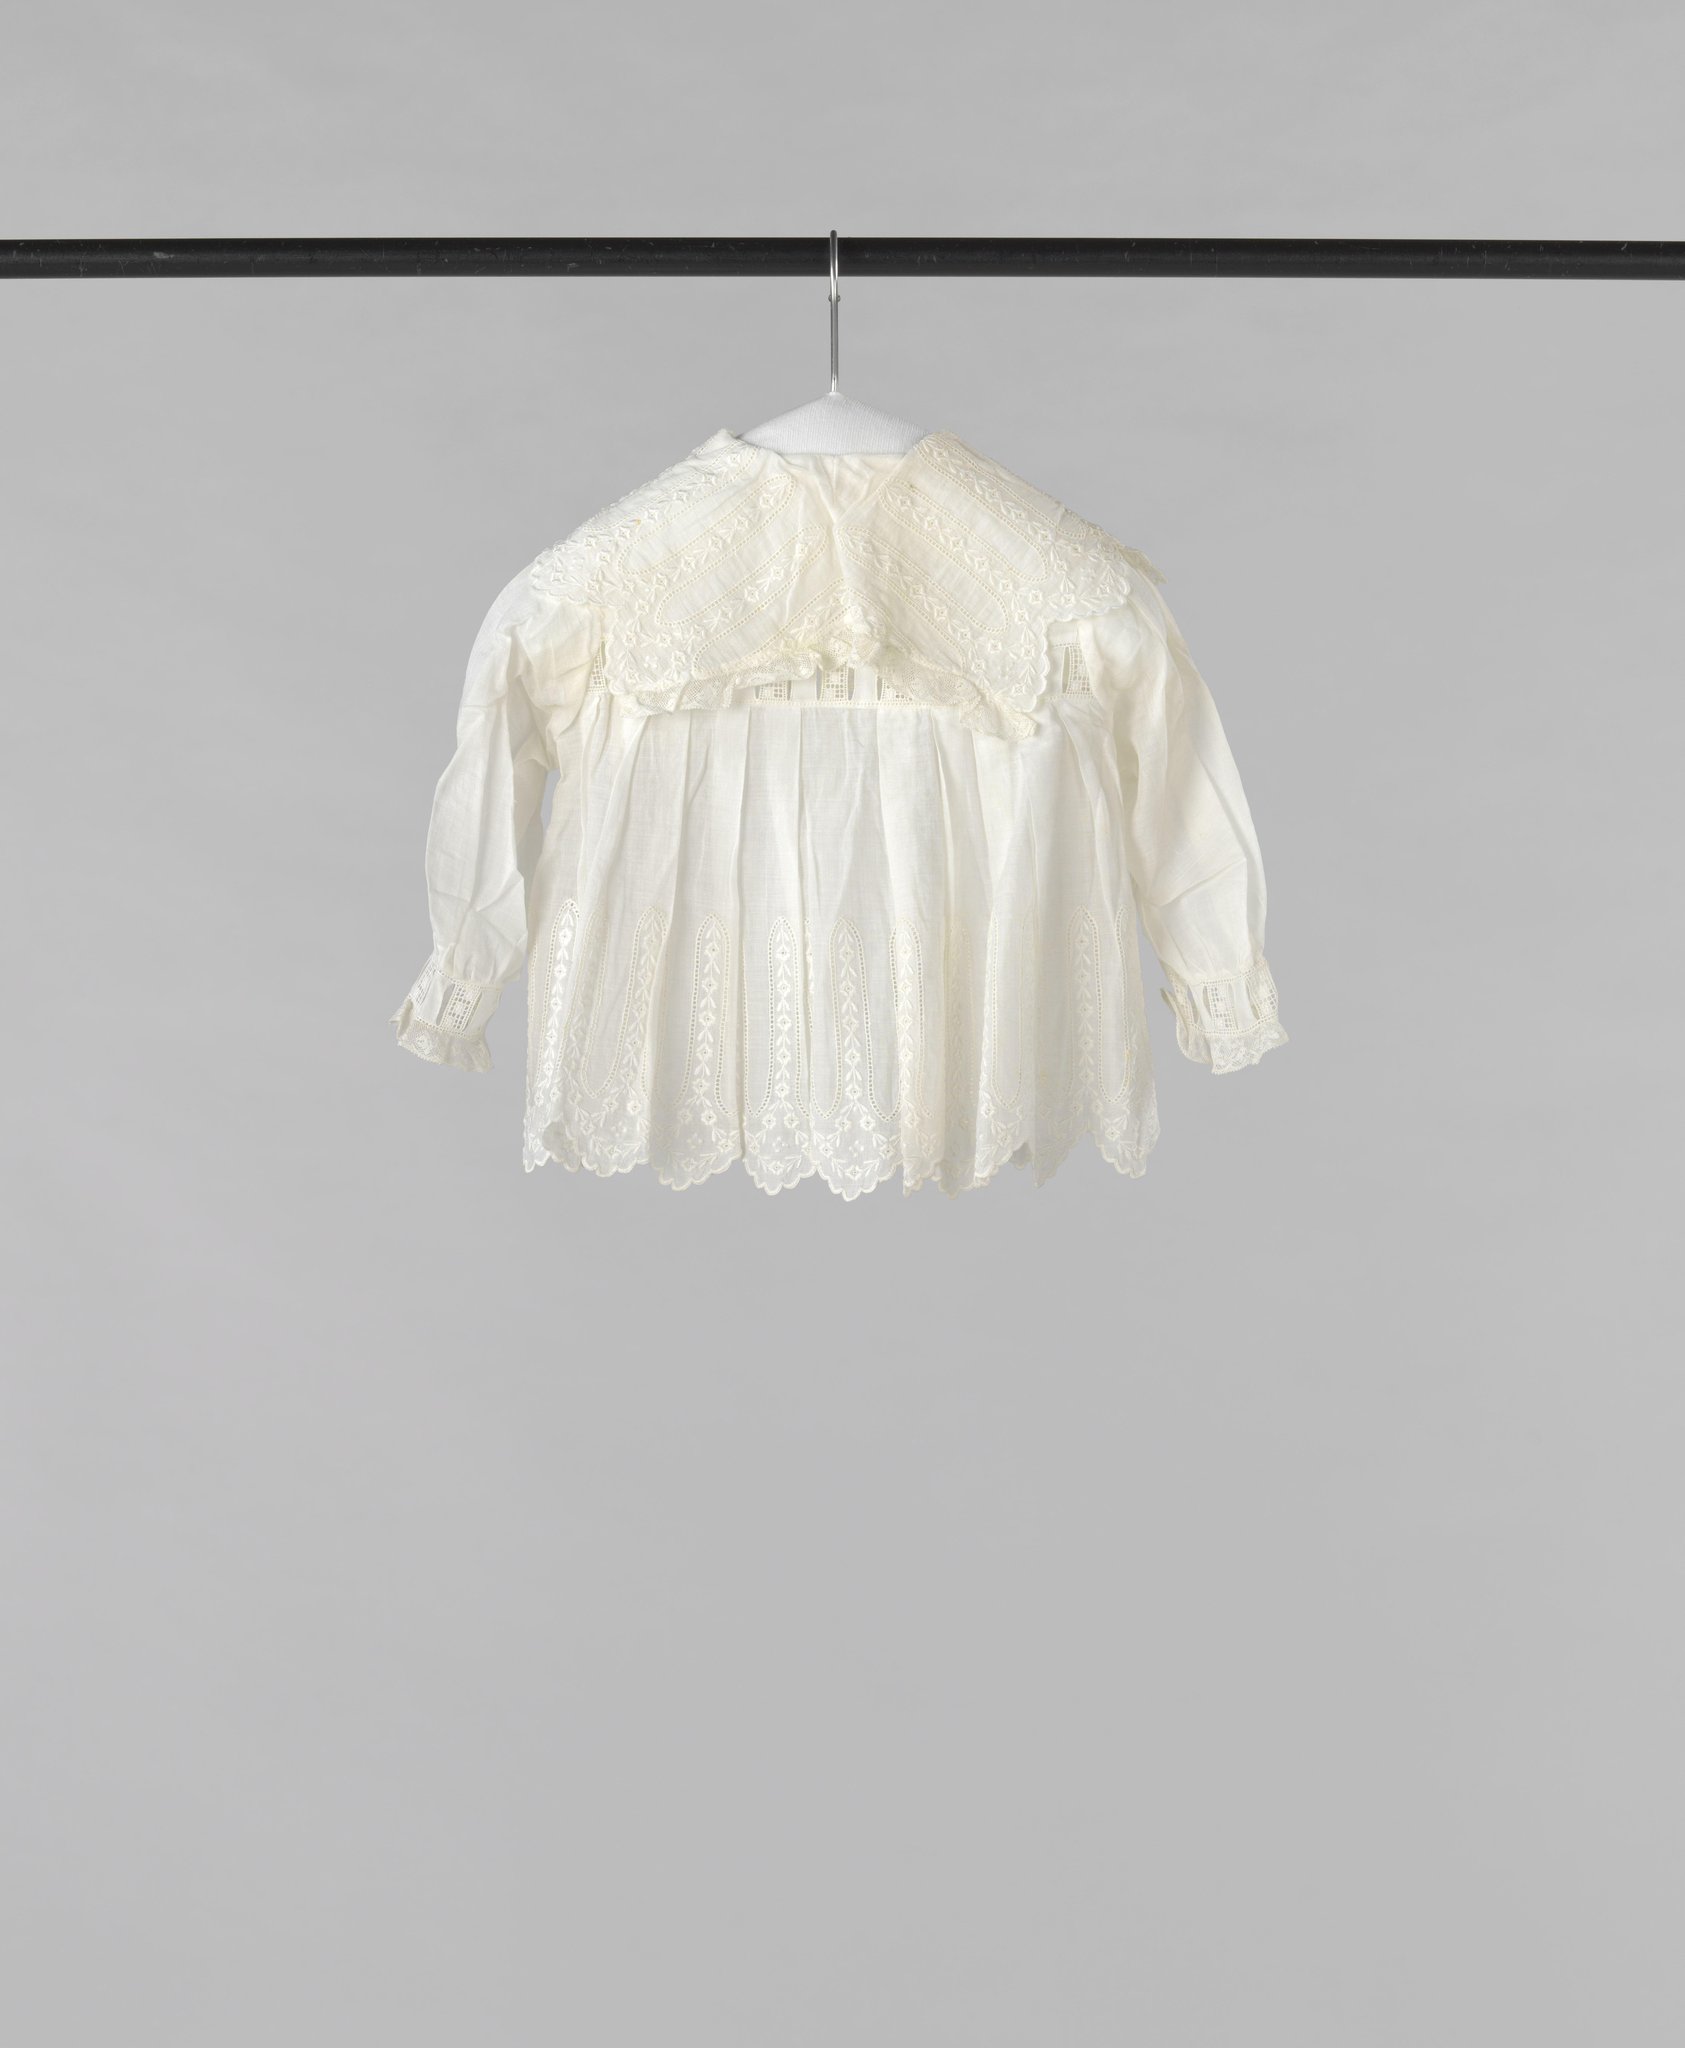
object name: childrenswear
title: Kiel met lange mouw voor een jongen, van wit linnenbatist.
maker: Anonymous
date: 1900-1925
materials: textile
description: Kiel met lange mouw voor een jongen, van wit linnenbatist. Model: pas met onderaan een opengewerkte rand, waaronder in platte plooien de "rok" hangt, langs de onderzijde versierd met een schulprand met Perzisch ajour en een geborduurde bloemslinger in wit. Grote kraag met kant afgezet. Manchetten opengewerkt en afgezet met kant.